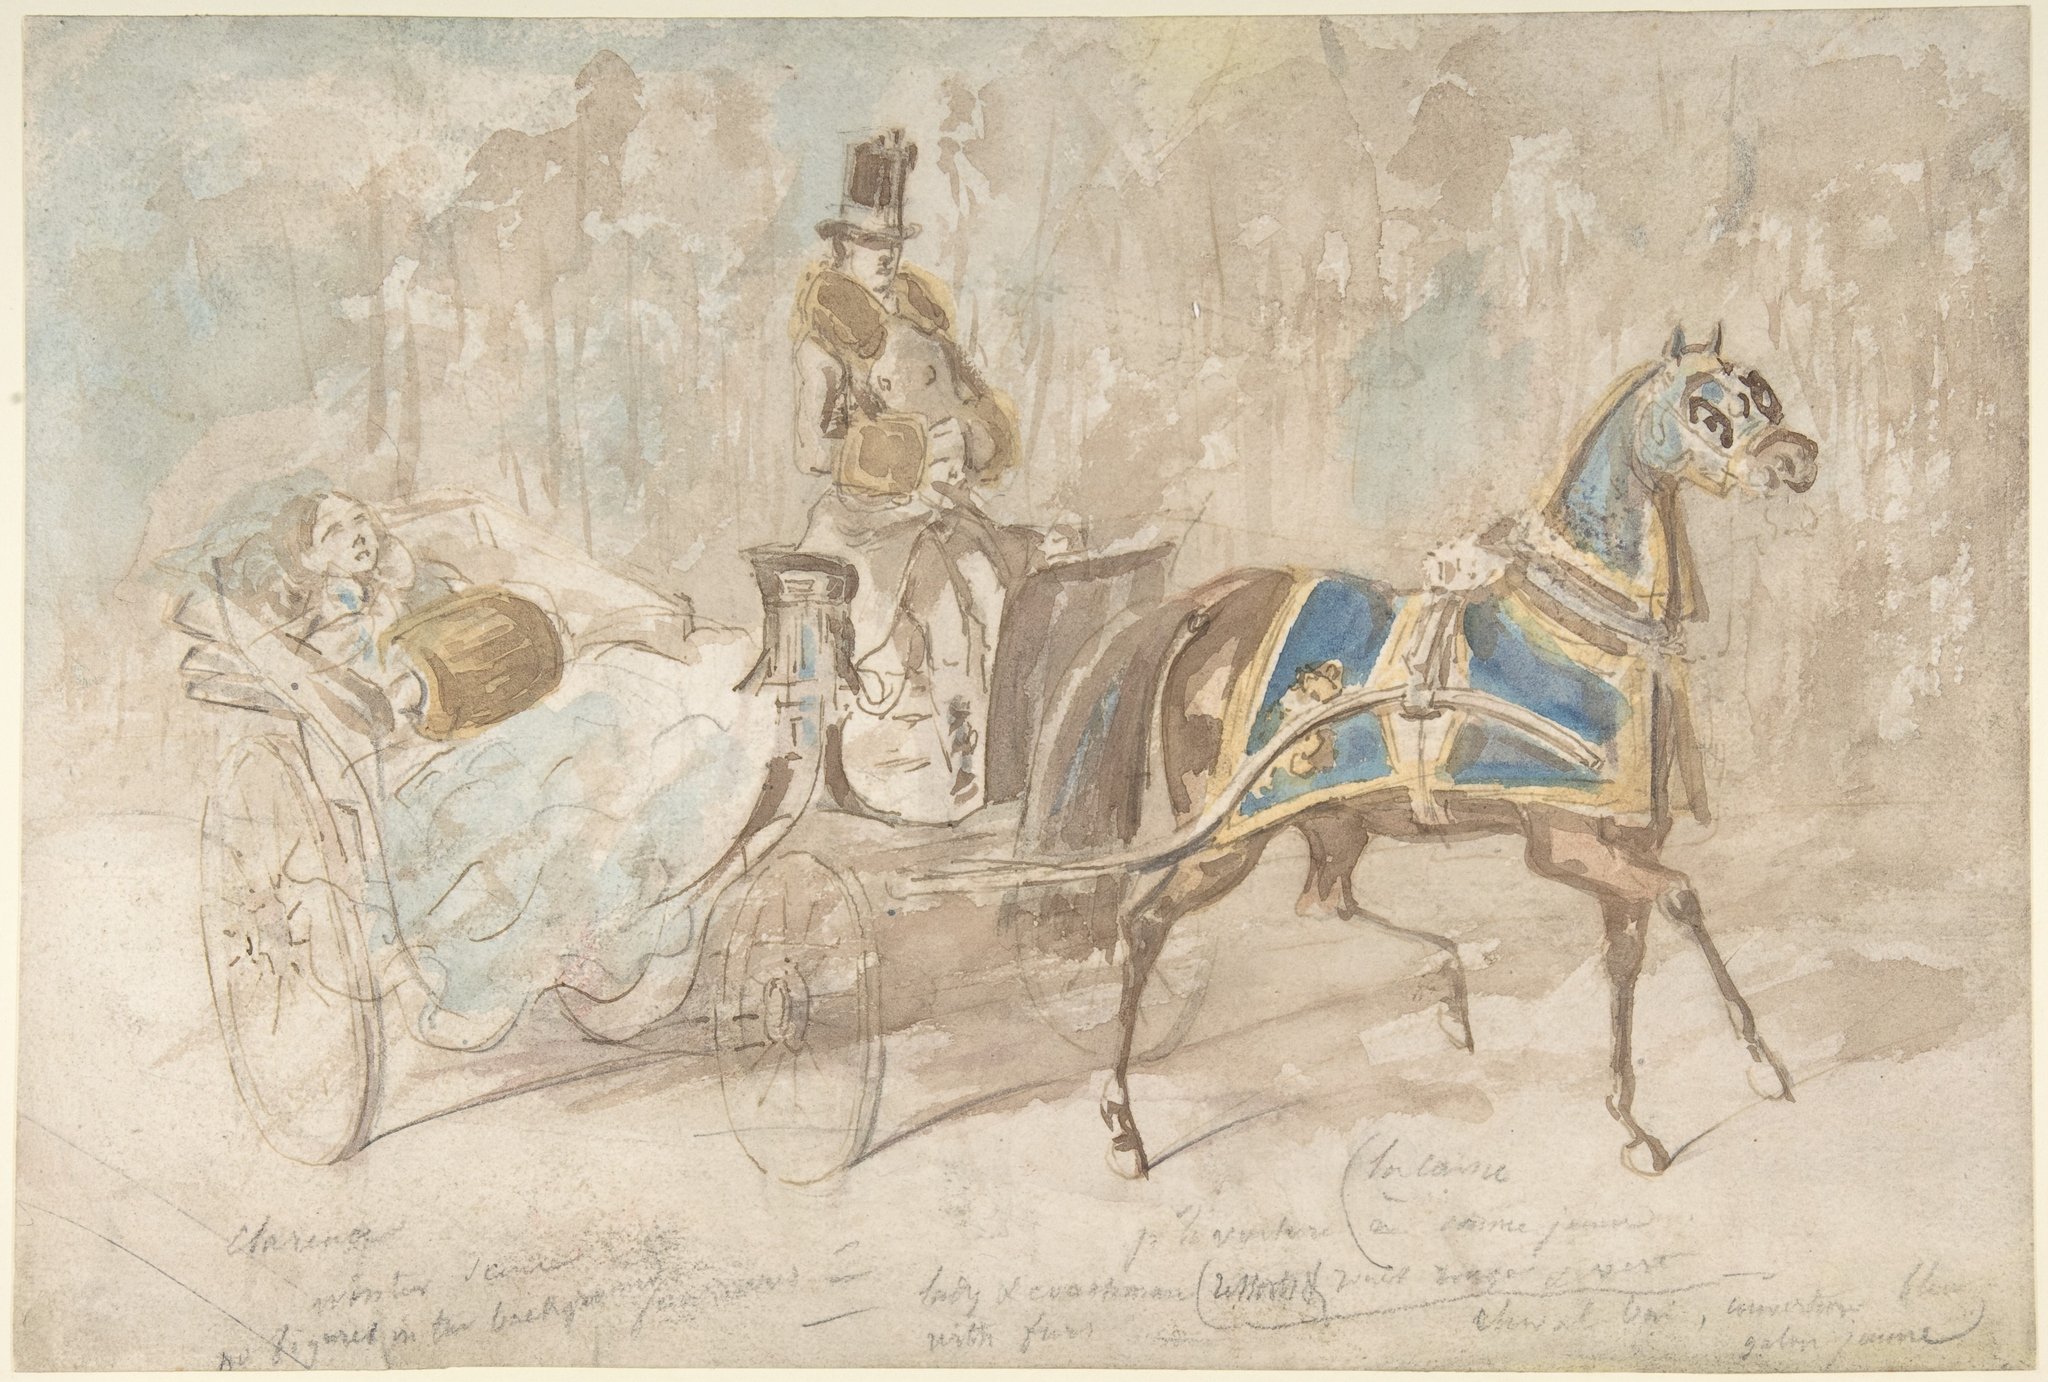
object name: drawing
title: Winter Drive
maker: constantin guys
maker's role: artist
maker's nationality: french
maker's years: 1802-1892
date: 1801-1900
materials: graphite, ink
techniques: pen, wash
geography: france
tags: men,women,horses,carriages